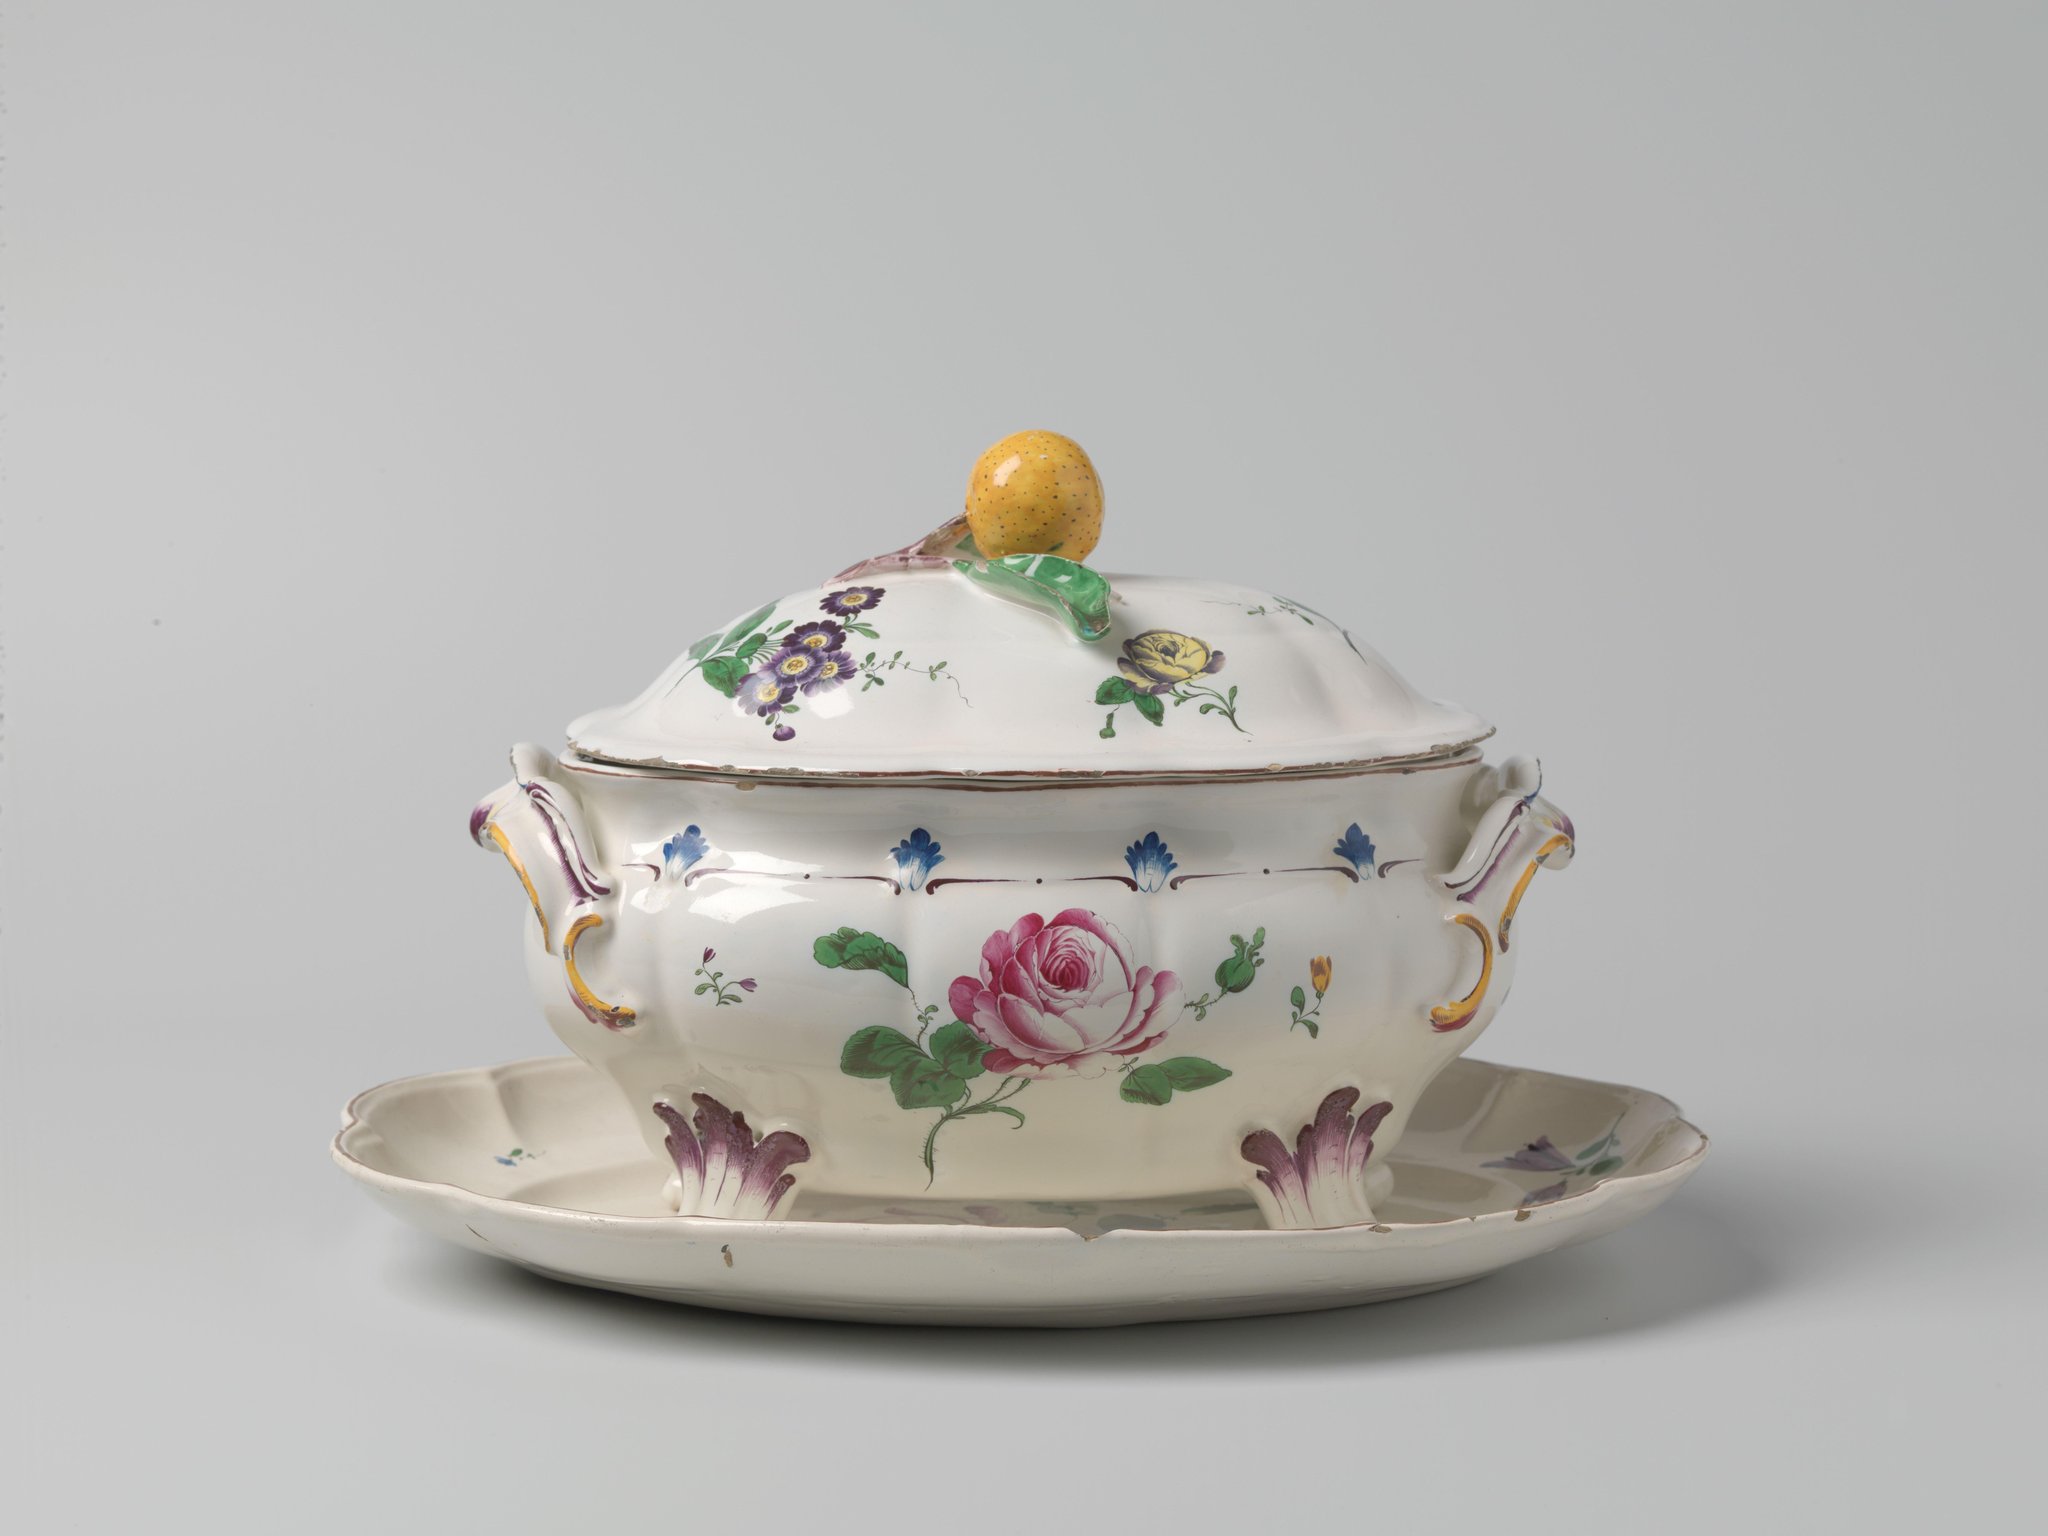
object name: platter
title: Onderschotel van terrine met deksel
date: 1760-1770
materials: faience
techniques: painted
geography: ludwigsburg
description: Onderschotel van terrine met deksel, veelkleurig versierd met losse bloemtakjes. Gemerkt in blauw met dubbele C .Z.